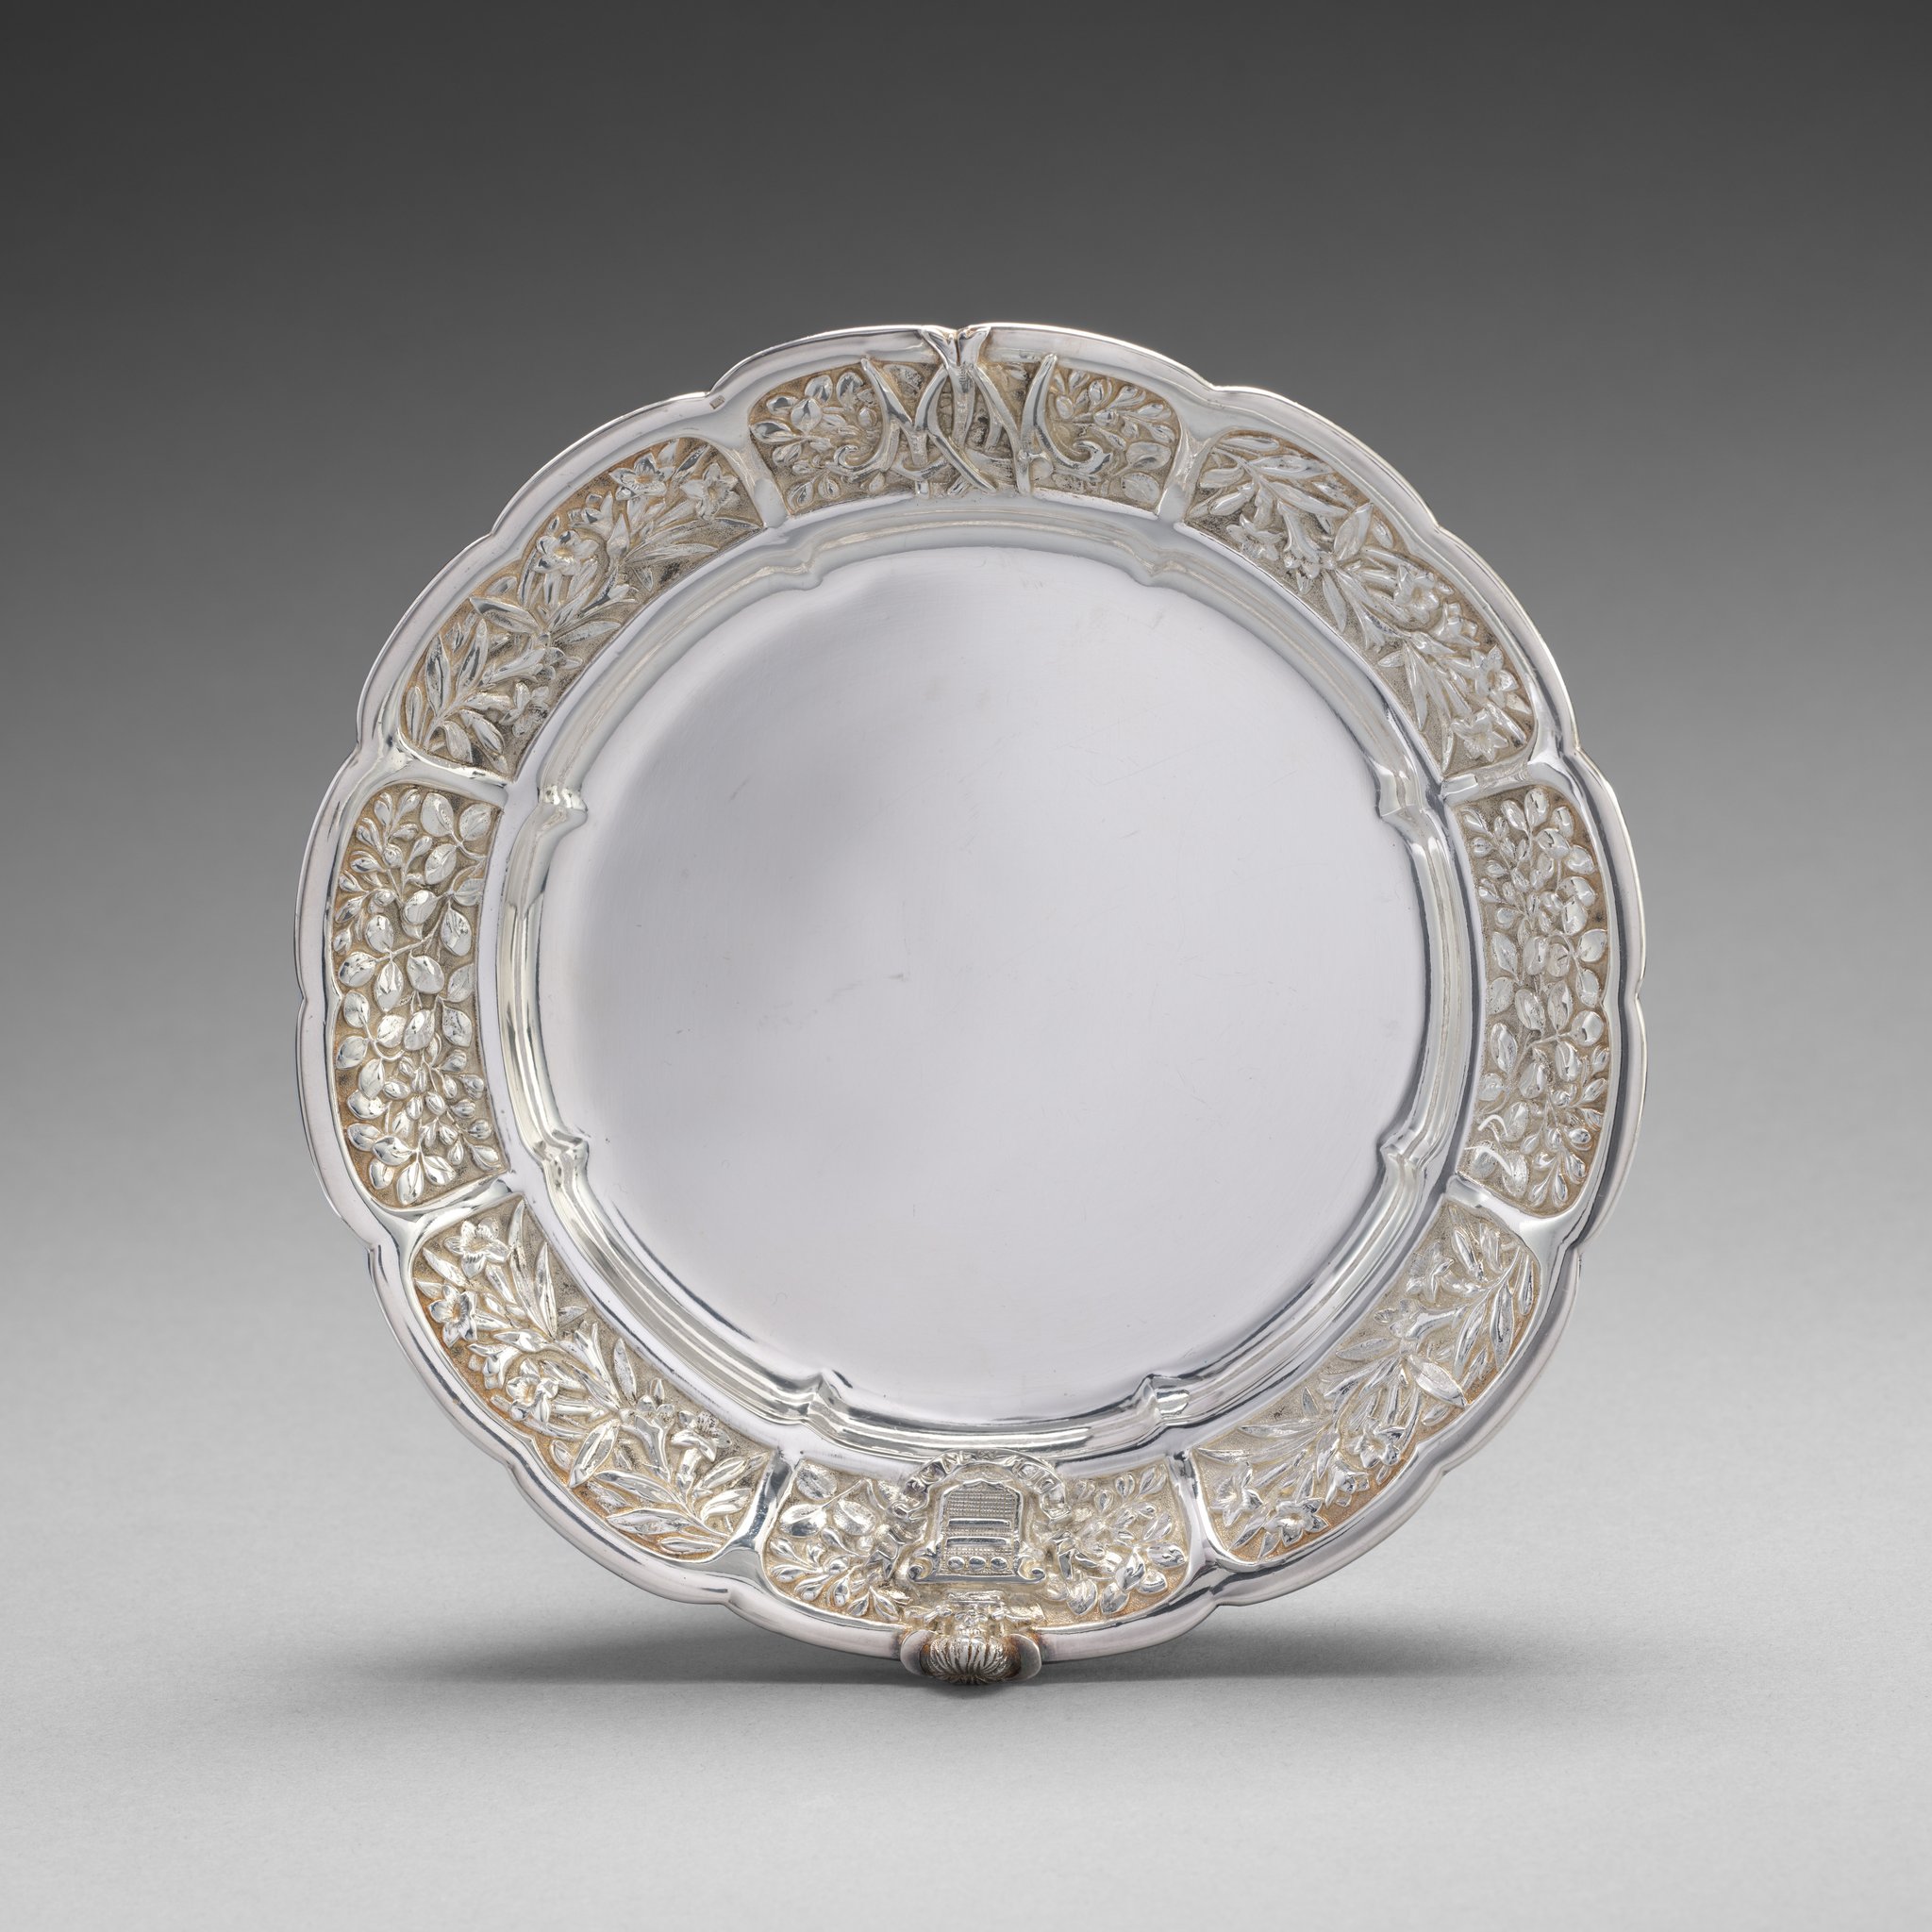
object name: ice cream plate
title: Ice Cream Plate from Mackay Service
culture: american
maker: tiffany & co.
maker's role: maker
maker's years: 1837-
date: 1878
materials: silver